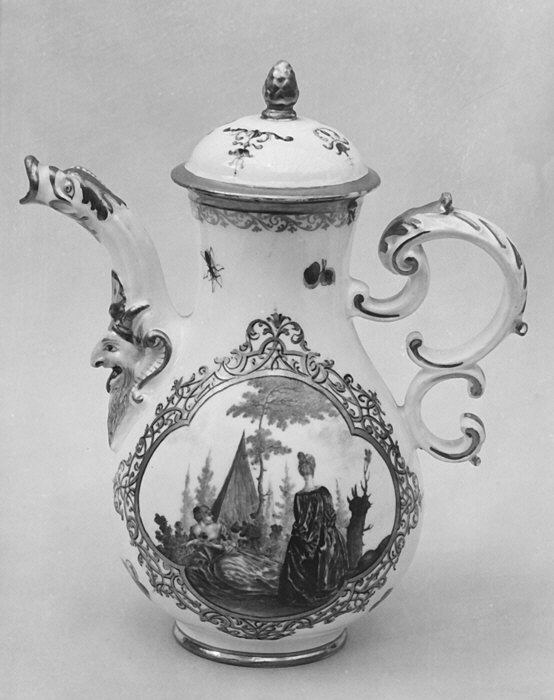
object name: coffeepot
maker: meissen manufactory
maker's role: manufactory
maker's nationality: german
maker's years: 1710-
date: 1740-1745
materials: hard paste porcelain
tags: women